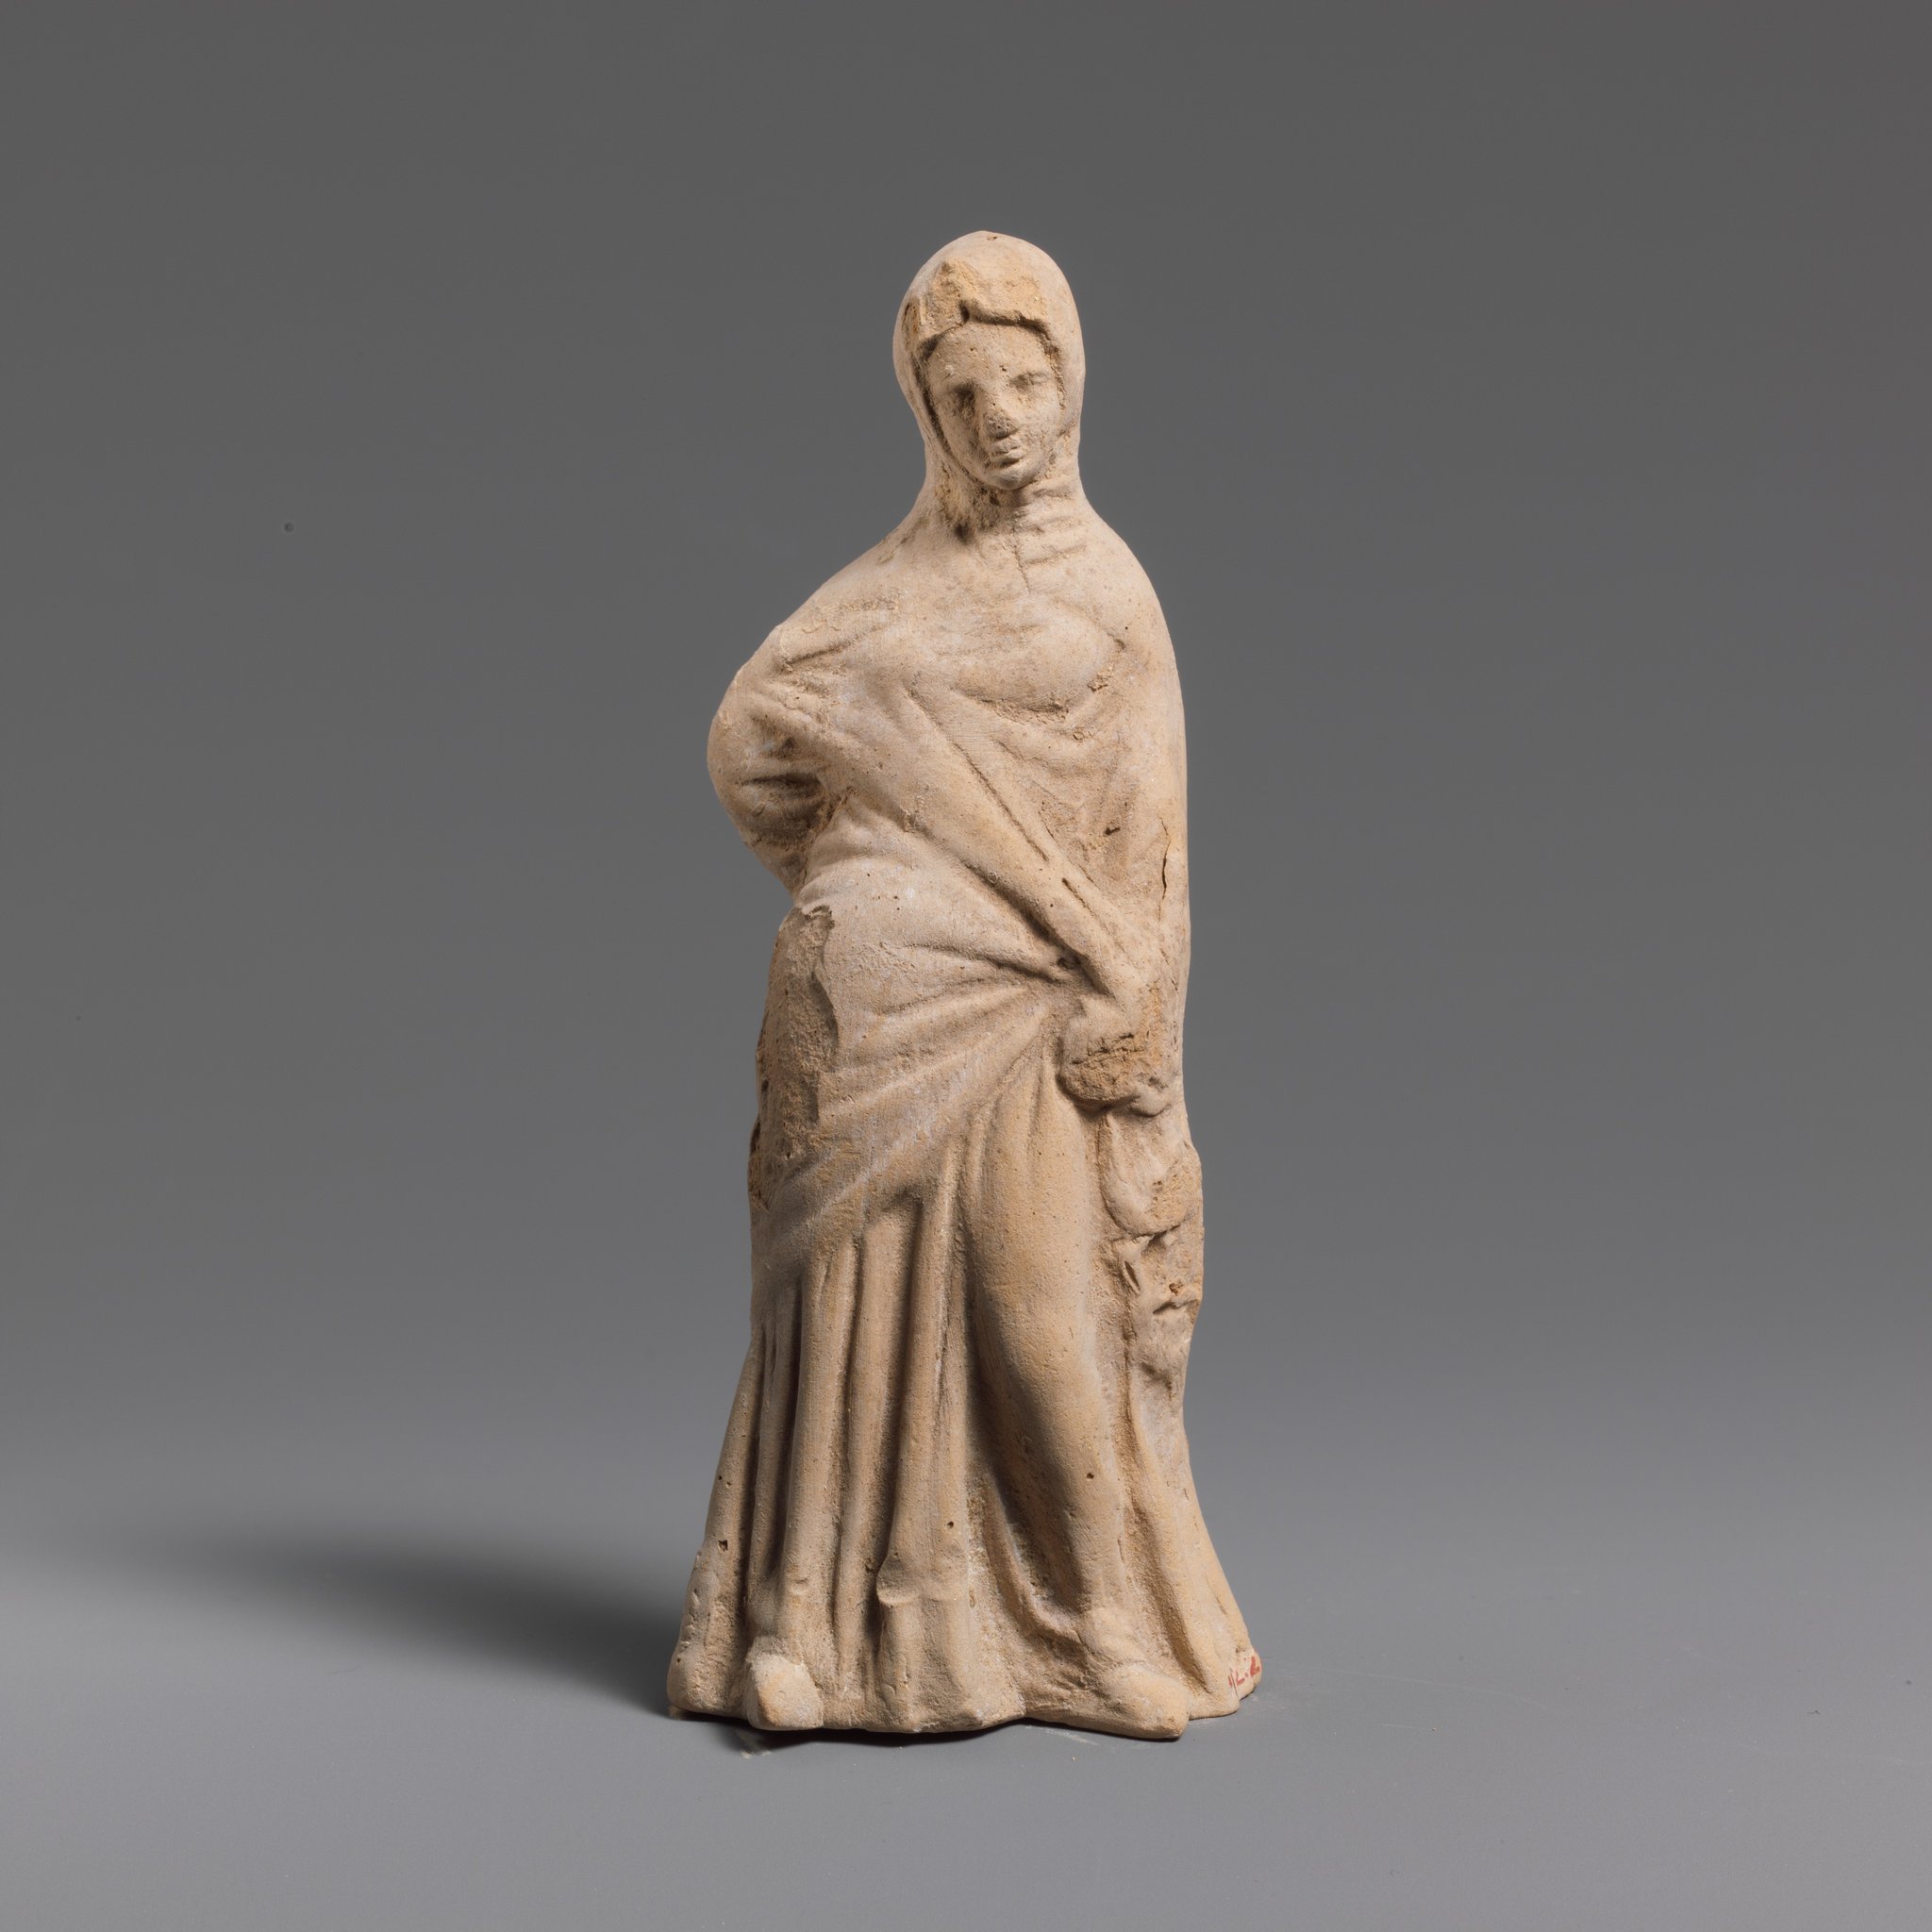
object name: statuette of a woman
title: Terracotta statuette of a woman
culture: greek, south italian, tarentine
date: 300-201 BCE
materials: terracotta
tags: women